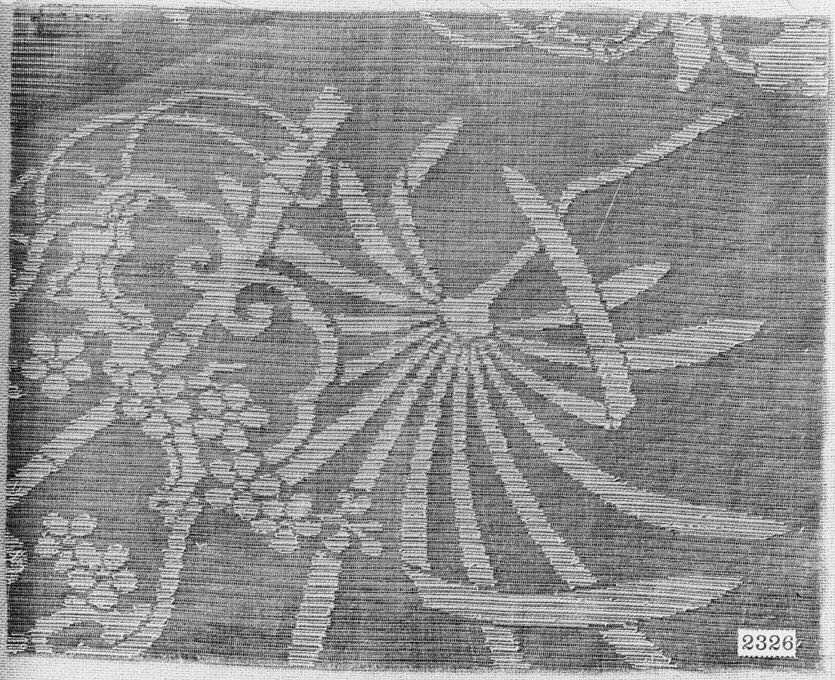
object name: piece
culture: japanese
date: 1801-1900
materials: silk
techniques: brocade